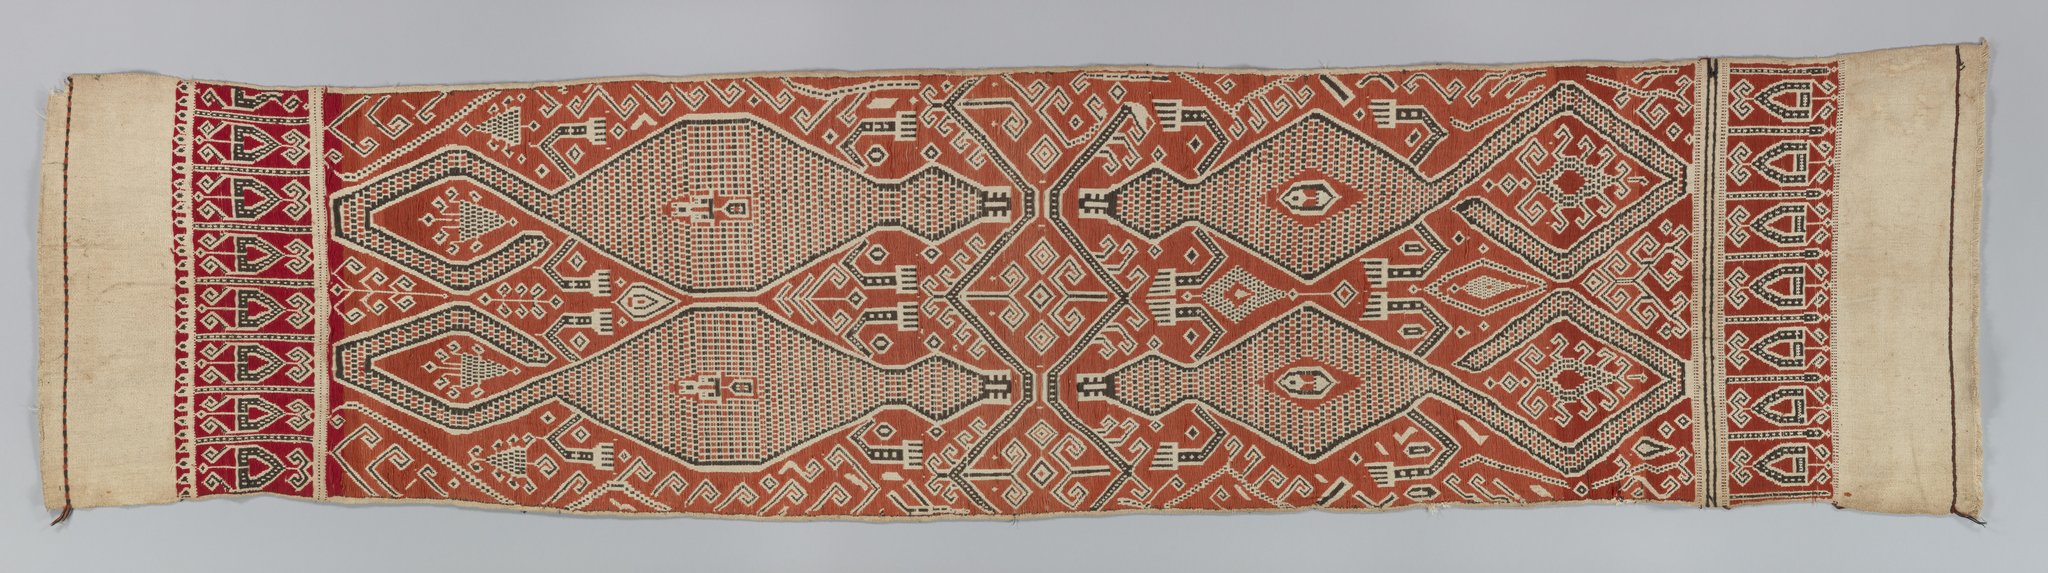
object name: cloth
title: Ceremonial cloth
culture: iban-dayak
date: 1801-1900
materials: cotton, textile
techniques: dyeing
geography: indonesia